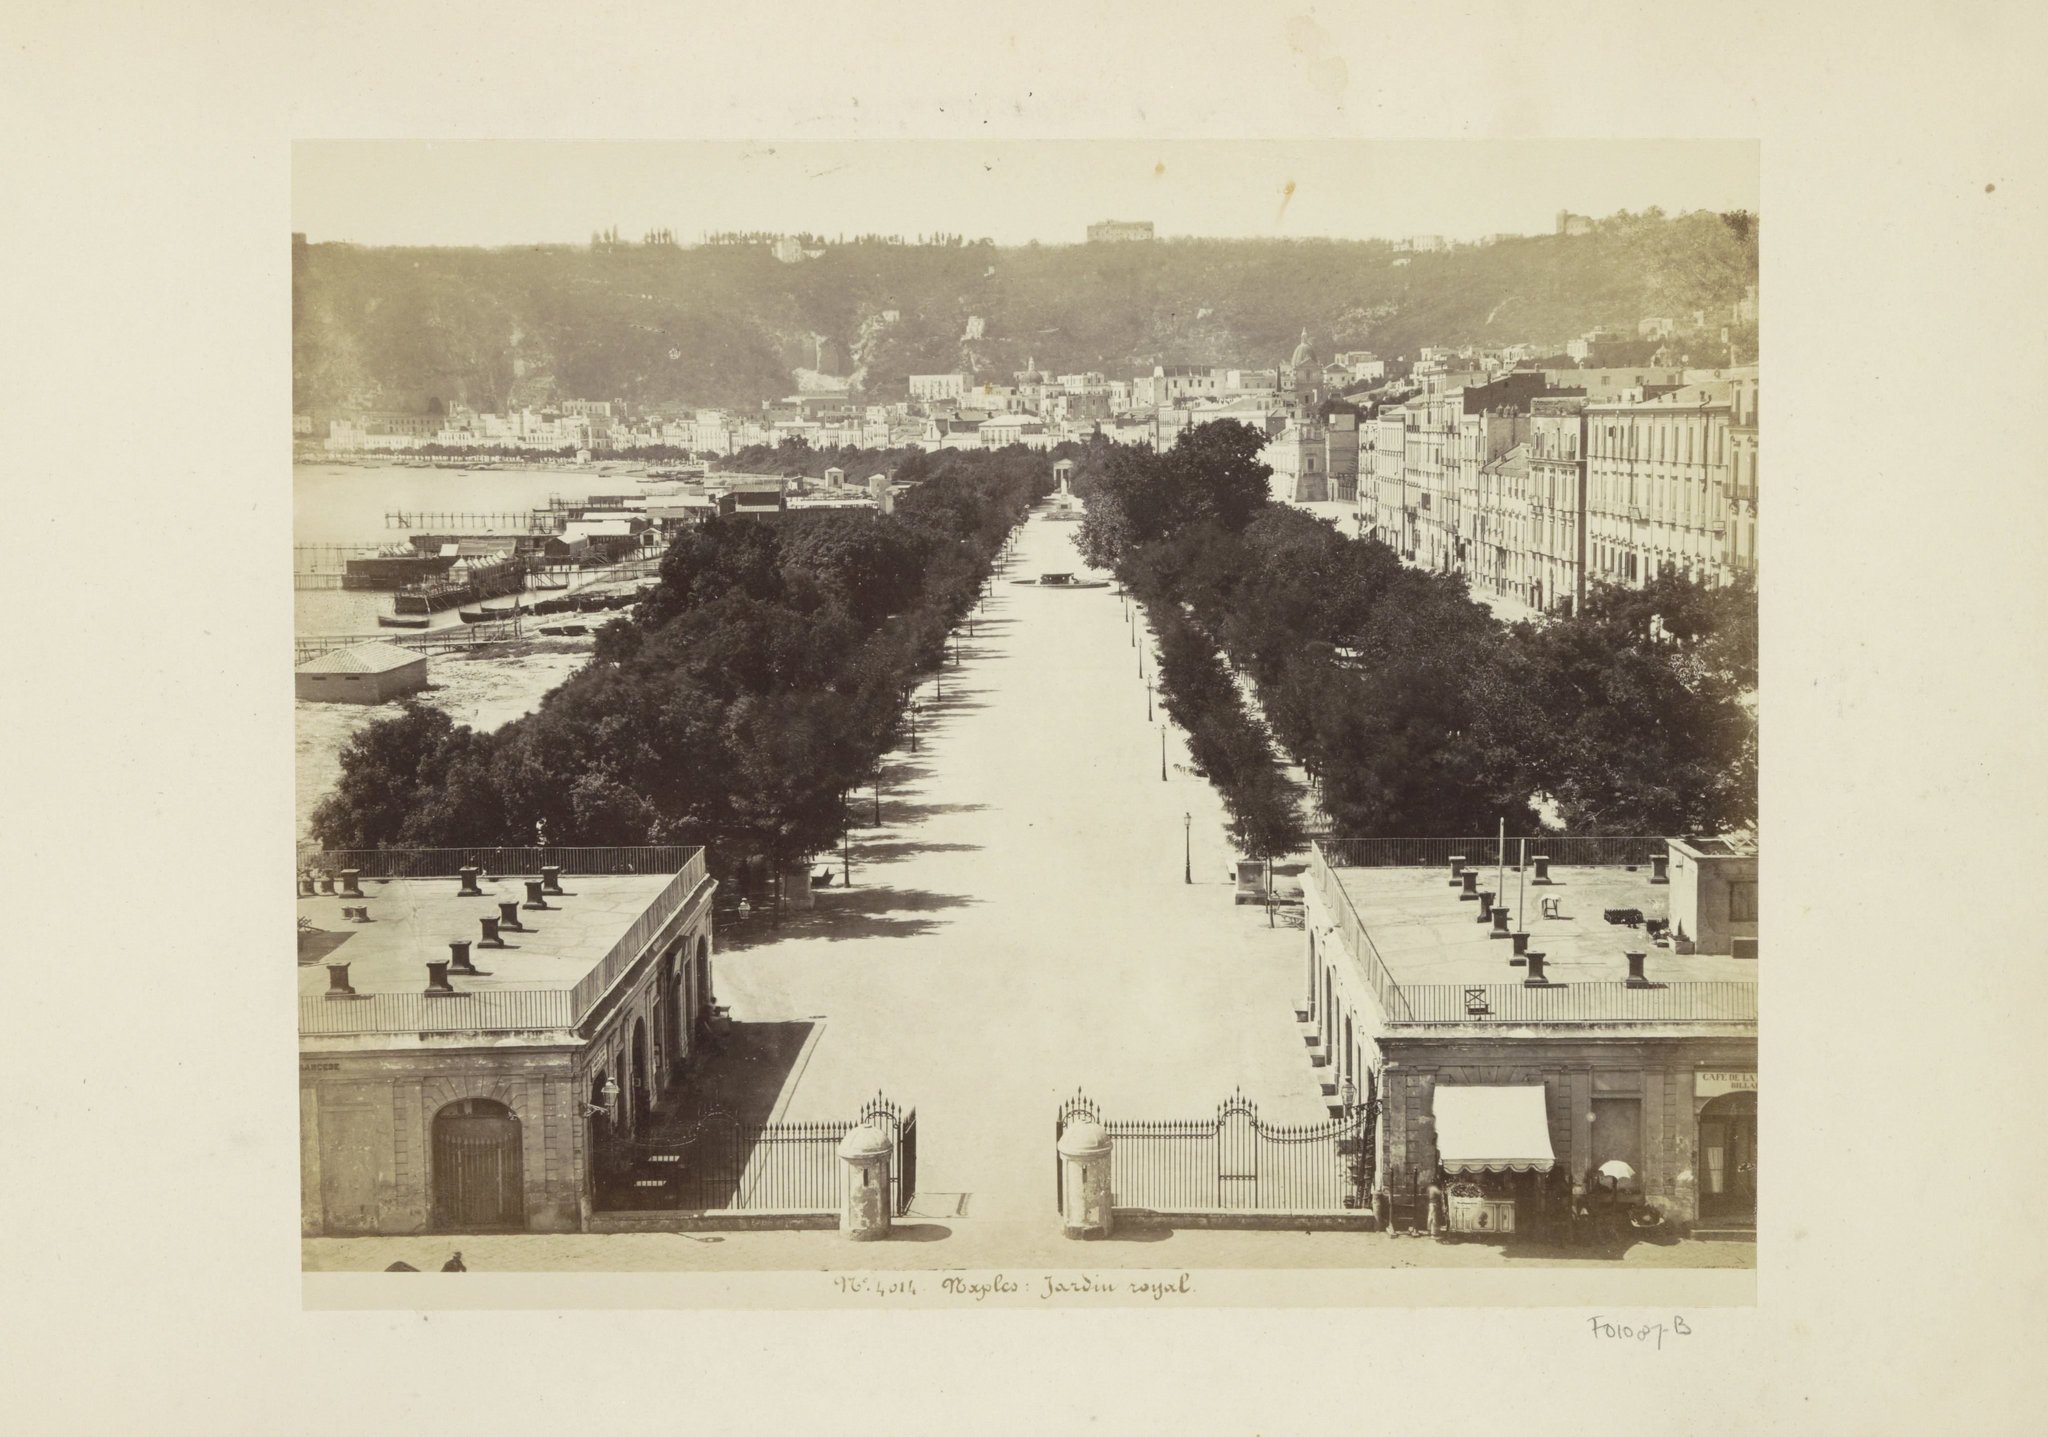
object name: photograph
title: Gezicht op de Koninklijke tuin in Napels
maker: Anonymous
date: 1865-1875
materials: paper, photographic support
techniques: albumen print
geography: naples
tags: public gardens, park (+ city(-scape) with figures, staffage), naples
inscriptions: negative number: ‘4014’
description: Onderdeel van Reisalbum met foto's van bezienswaardigheden in Napels en omgeving.